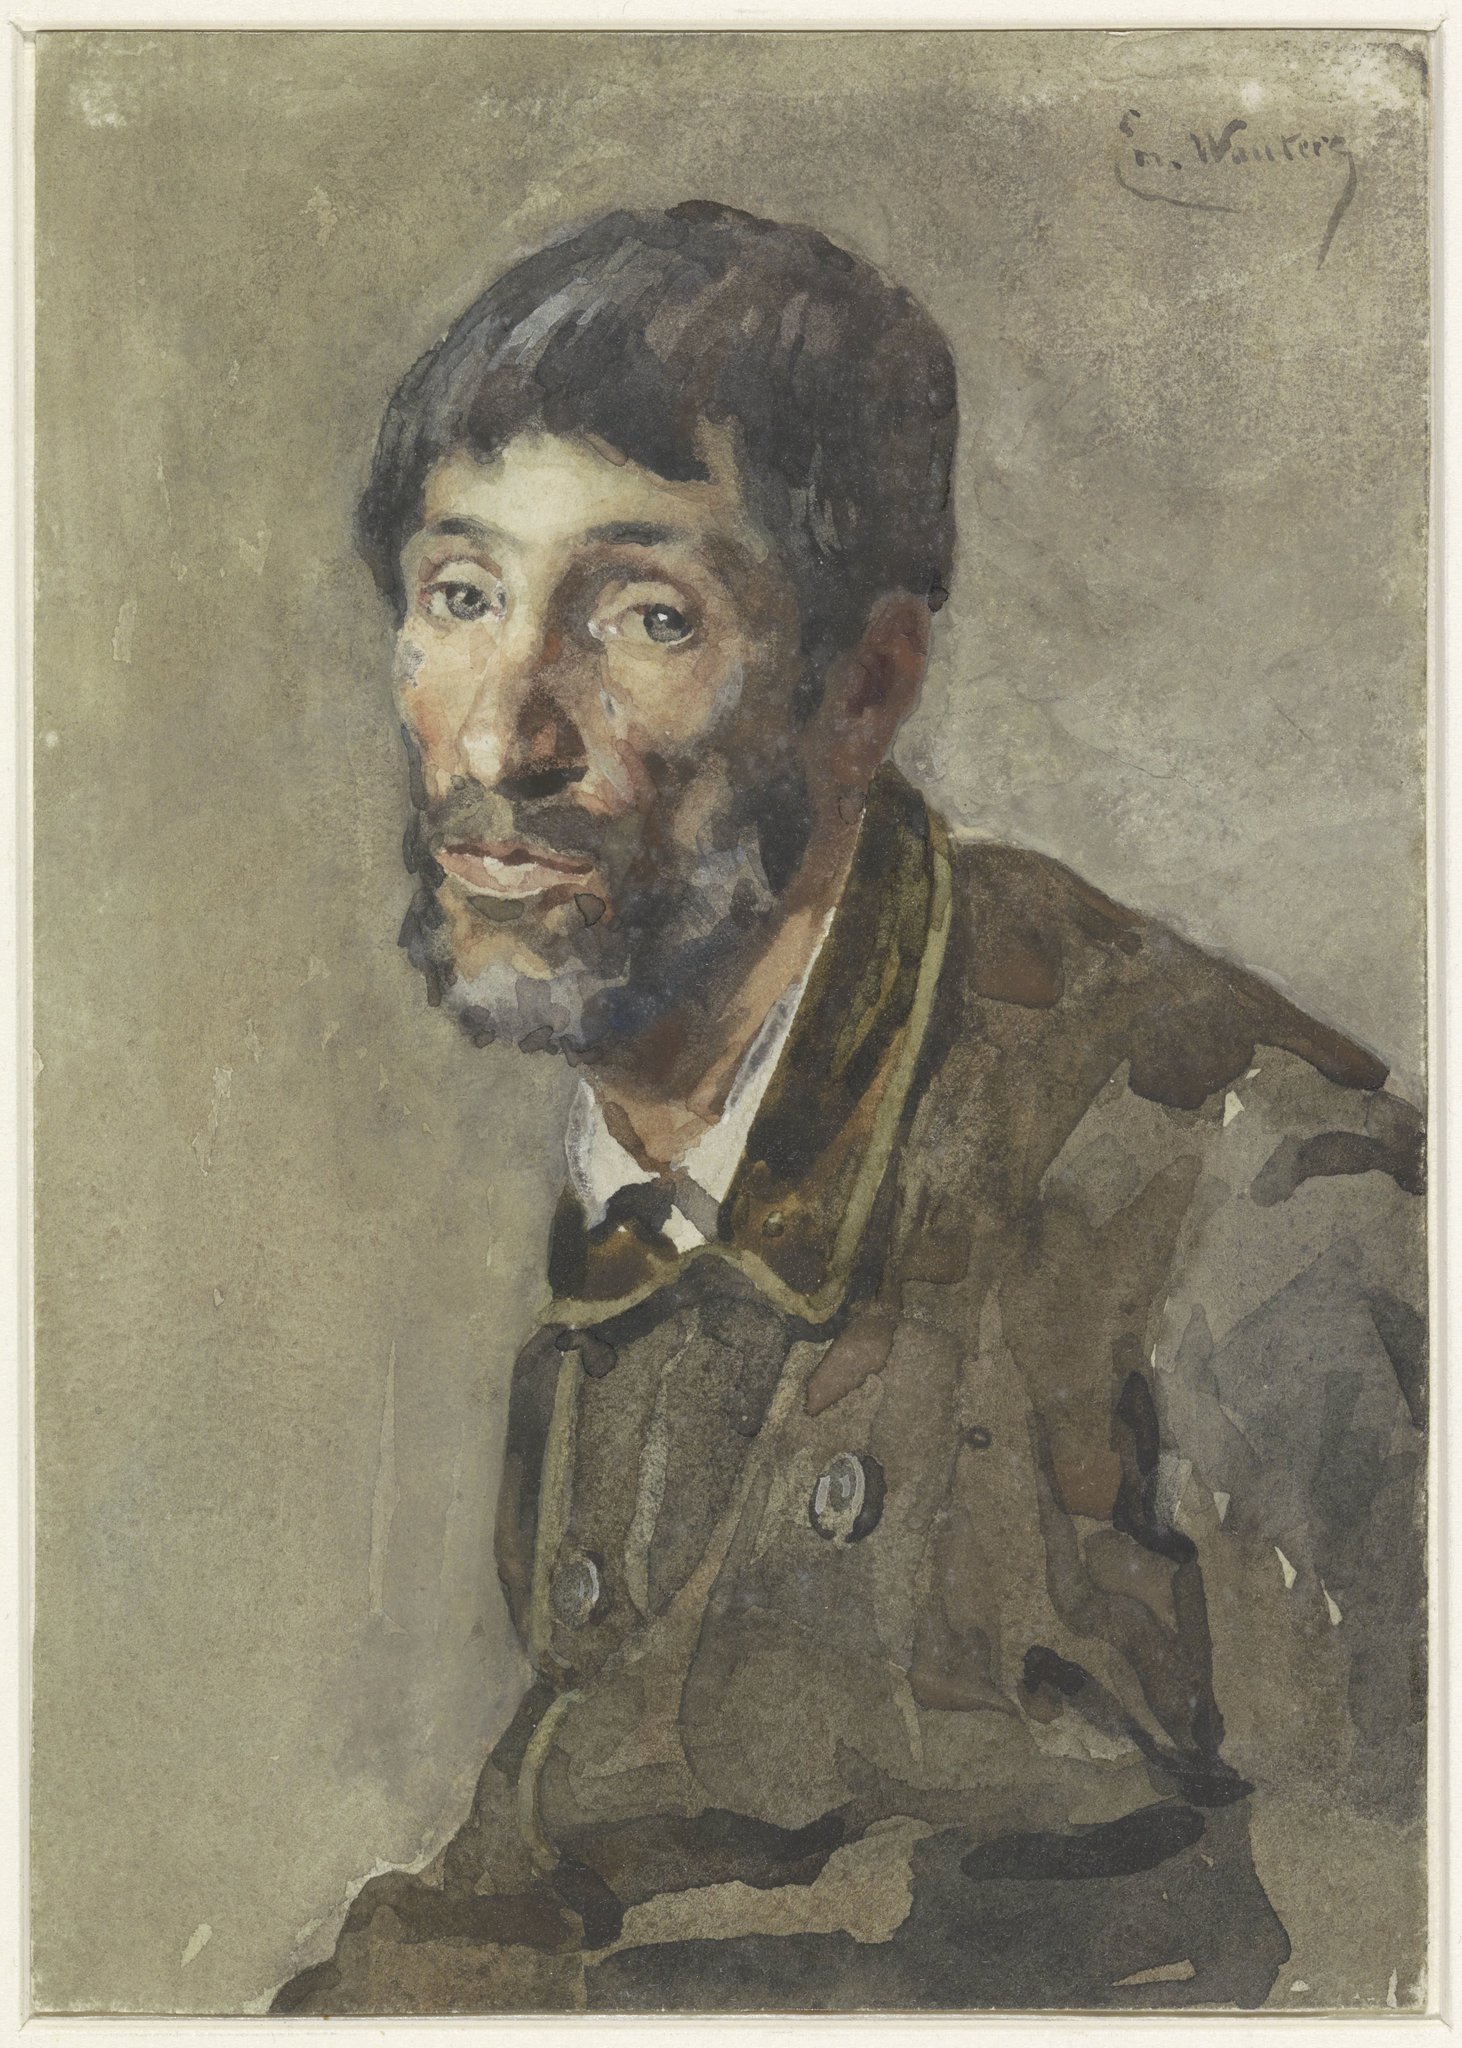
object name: drawing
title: Portret van een man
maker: emile charles wauters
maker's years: 1846-1933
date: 1856-1933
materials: paper, watercolor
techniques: brush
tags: anonymous historical person portrayed alone